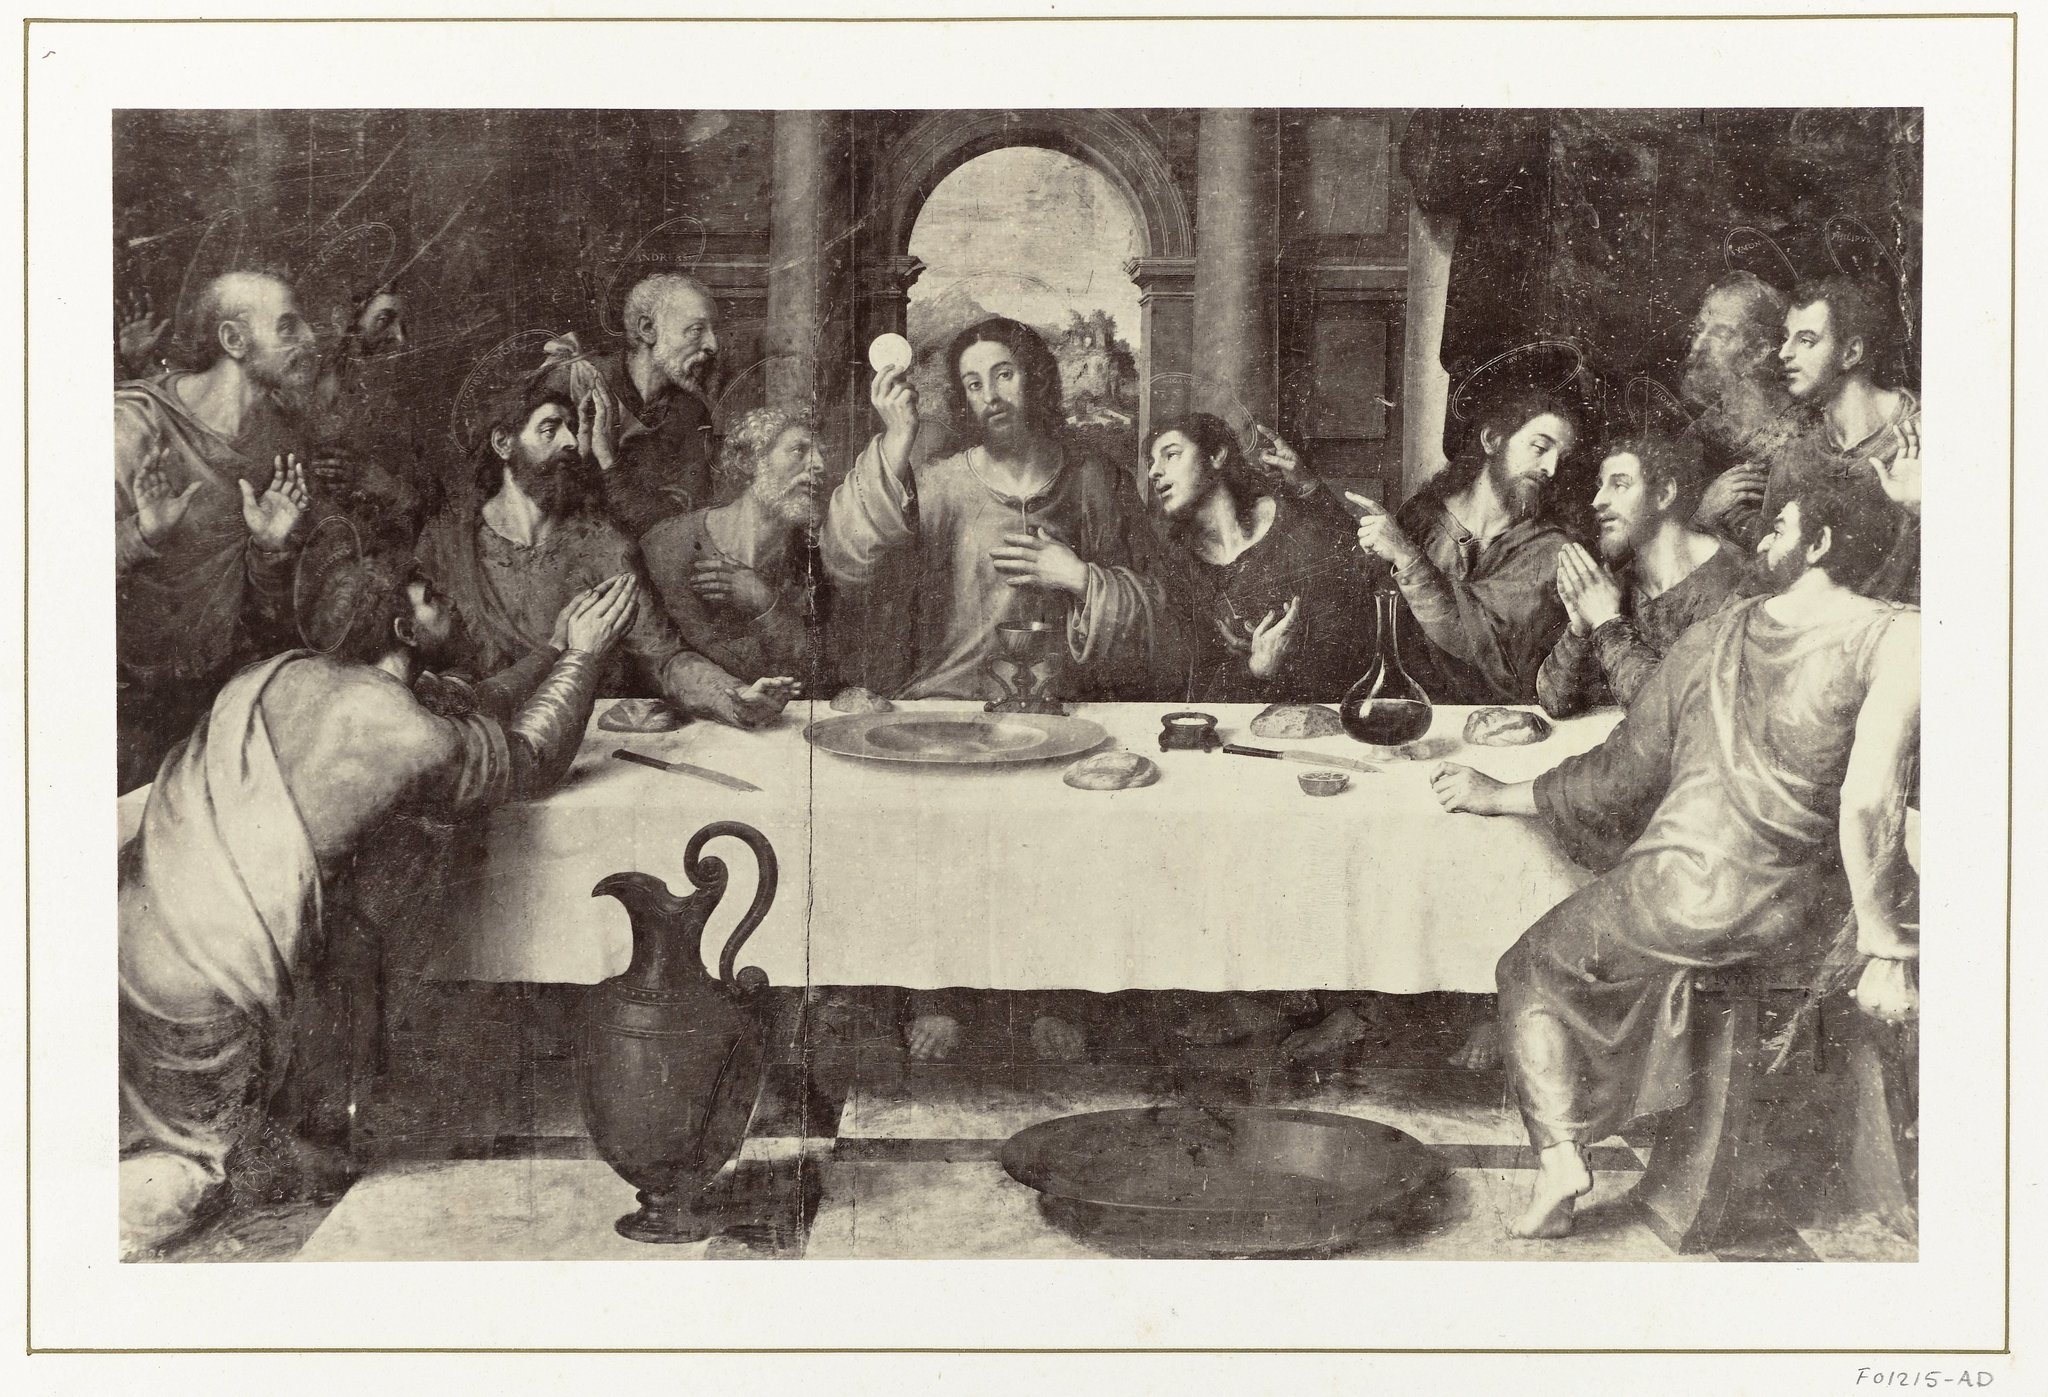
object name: photograph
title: Fotoreproductie van een schilderij door Juan de Juanes, voorstellend het Laatste Avondmaal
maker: Anonymous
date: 1860-1875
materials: photographic support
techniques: albumen print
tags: last supper (in general) (matthew 26:21-35; mark 14:18-31; luke 22:3, 22:15-23; john 13:21-38)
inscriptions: inscription: ‘cuadros del Rl. Museo M[...]’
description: Onderdeel van Reisalbum met opnames van kunstwerken, personen en bezienswaardigheden in Spanje.